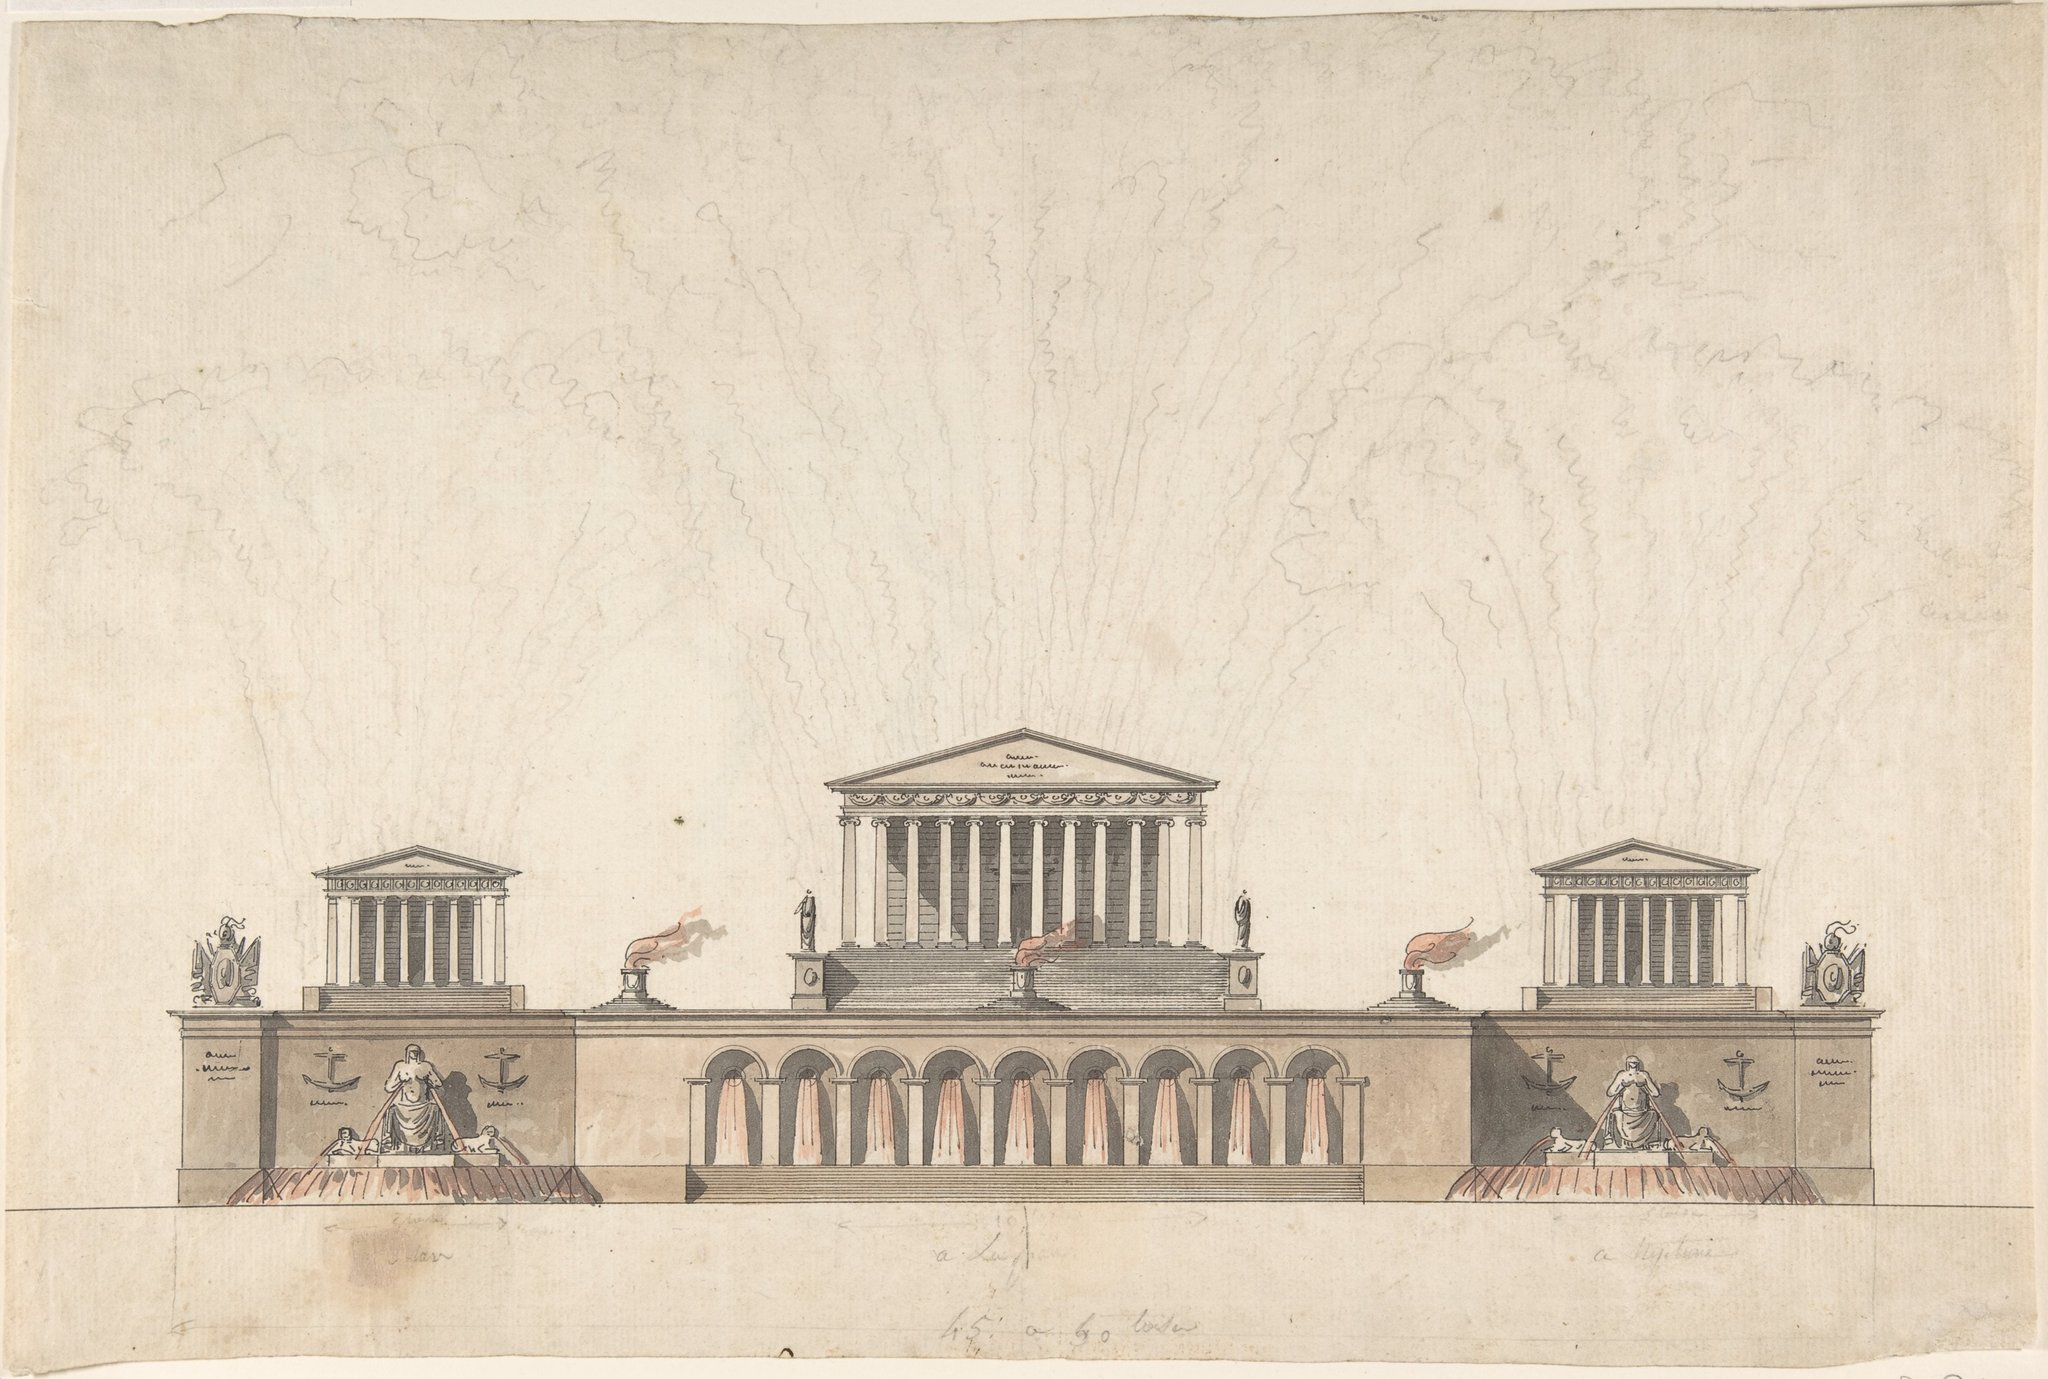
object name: drawing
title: Fireworks for a Naval Victory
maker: anonymous, italian, 18th or early 19th century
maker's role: artist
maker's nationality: italian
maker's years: 1700-1850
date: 1800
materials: ink, drawing material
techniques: pen, wash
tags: buildings